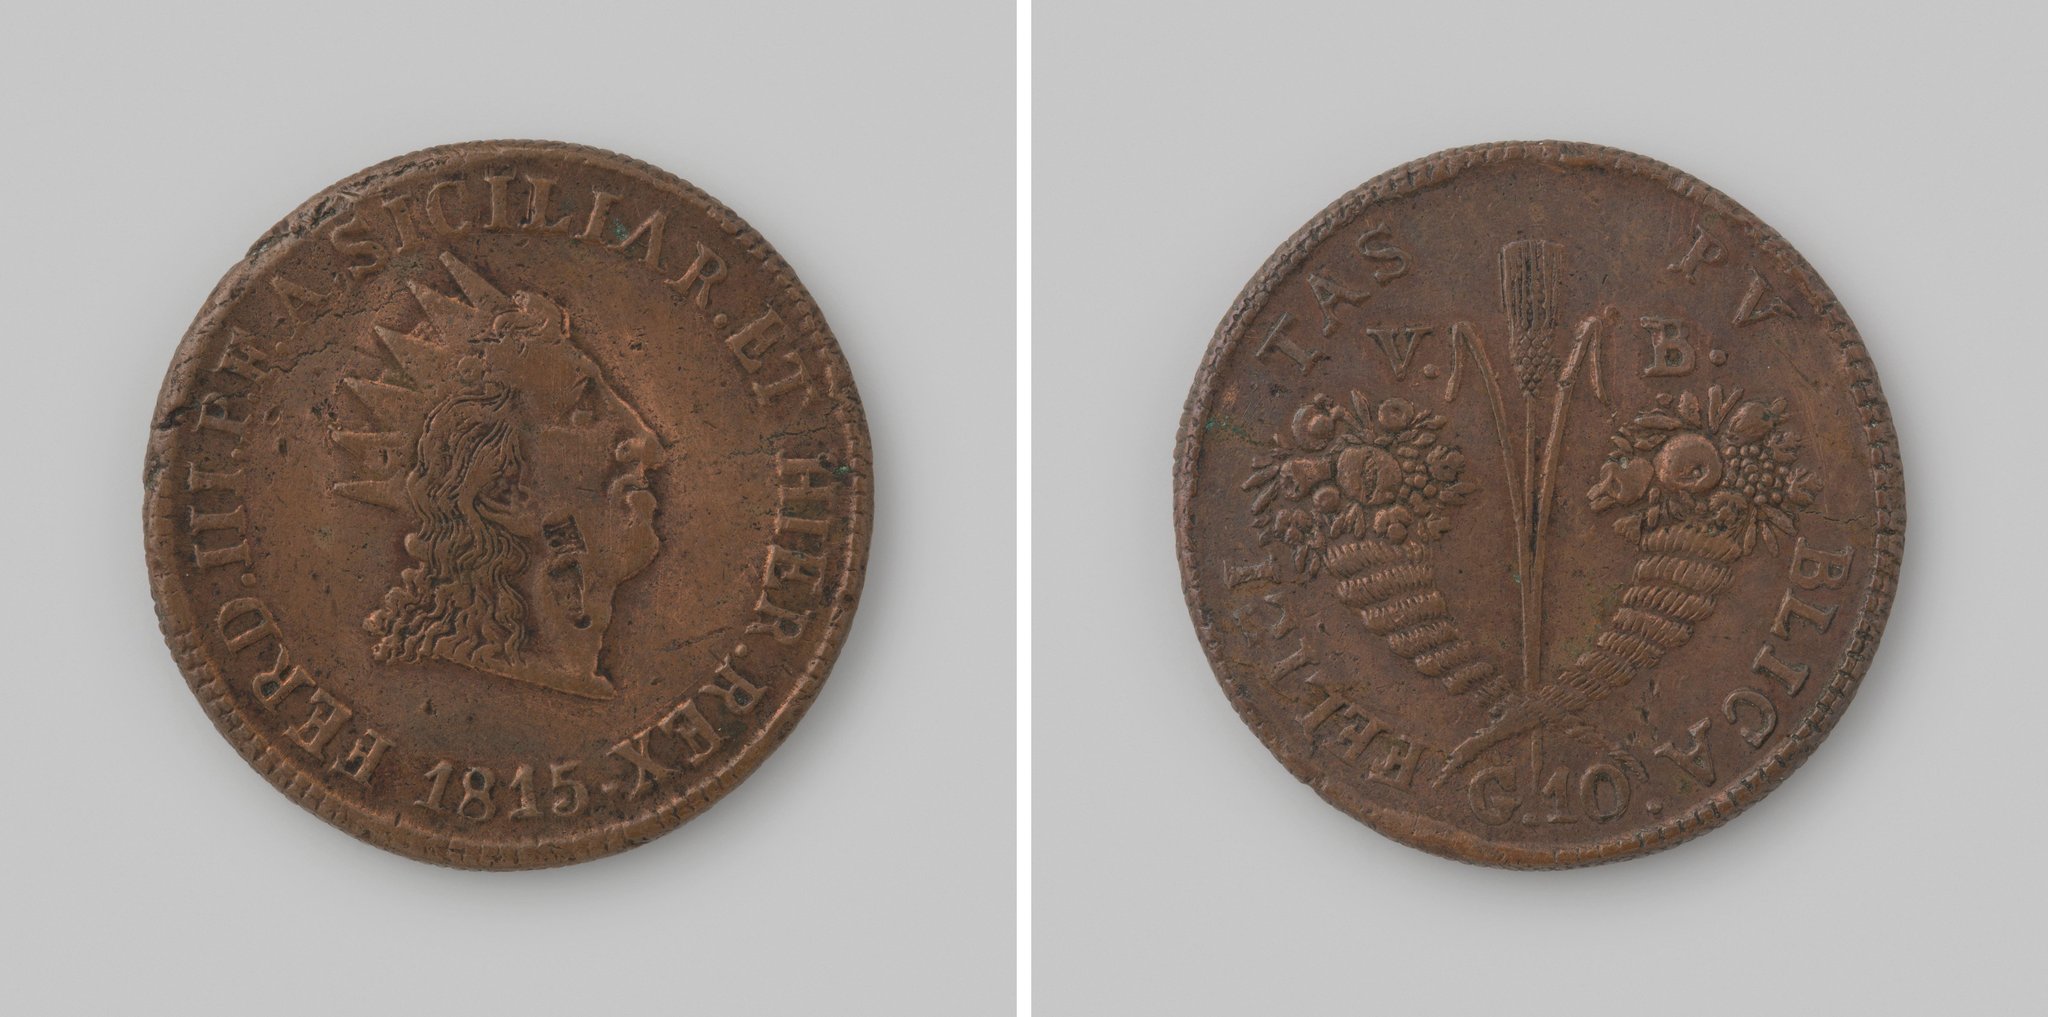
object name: coin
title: 10 grani uit het Koninkrijk der Beide Siciliën van Ferdinand III, 1815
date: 1815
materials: copper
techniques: striking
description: Koperen munt. Voorzijde: hoofd met stralenkroon naar rechts. Jaartal onderaan. Keerzijde: tussen twee hoornen des overvloeds korenaar. Waarde-aanduiding onderaan. Kartelrand. NB: op voorzijde zijn twee merktekens aangebracht.